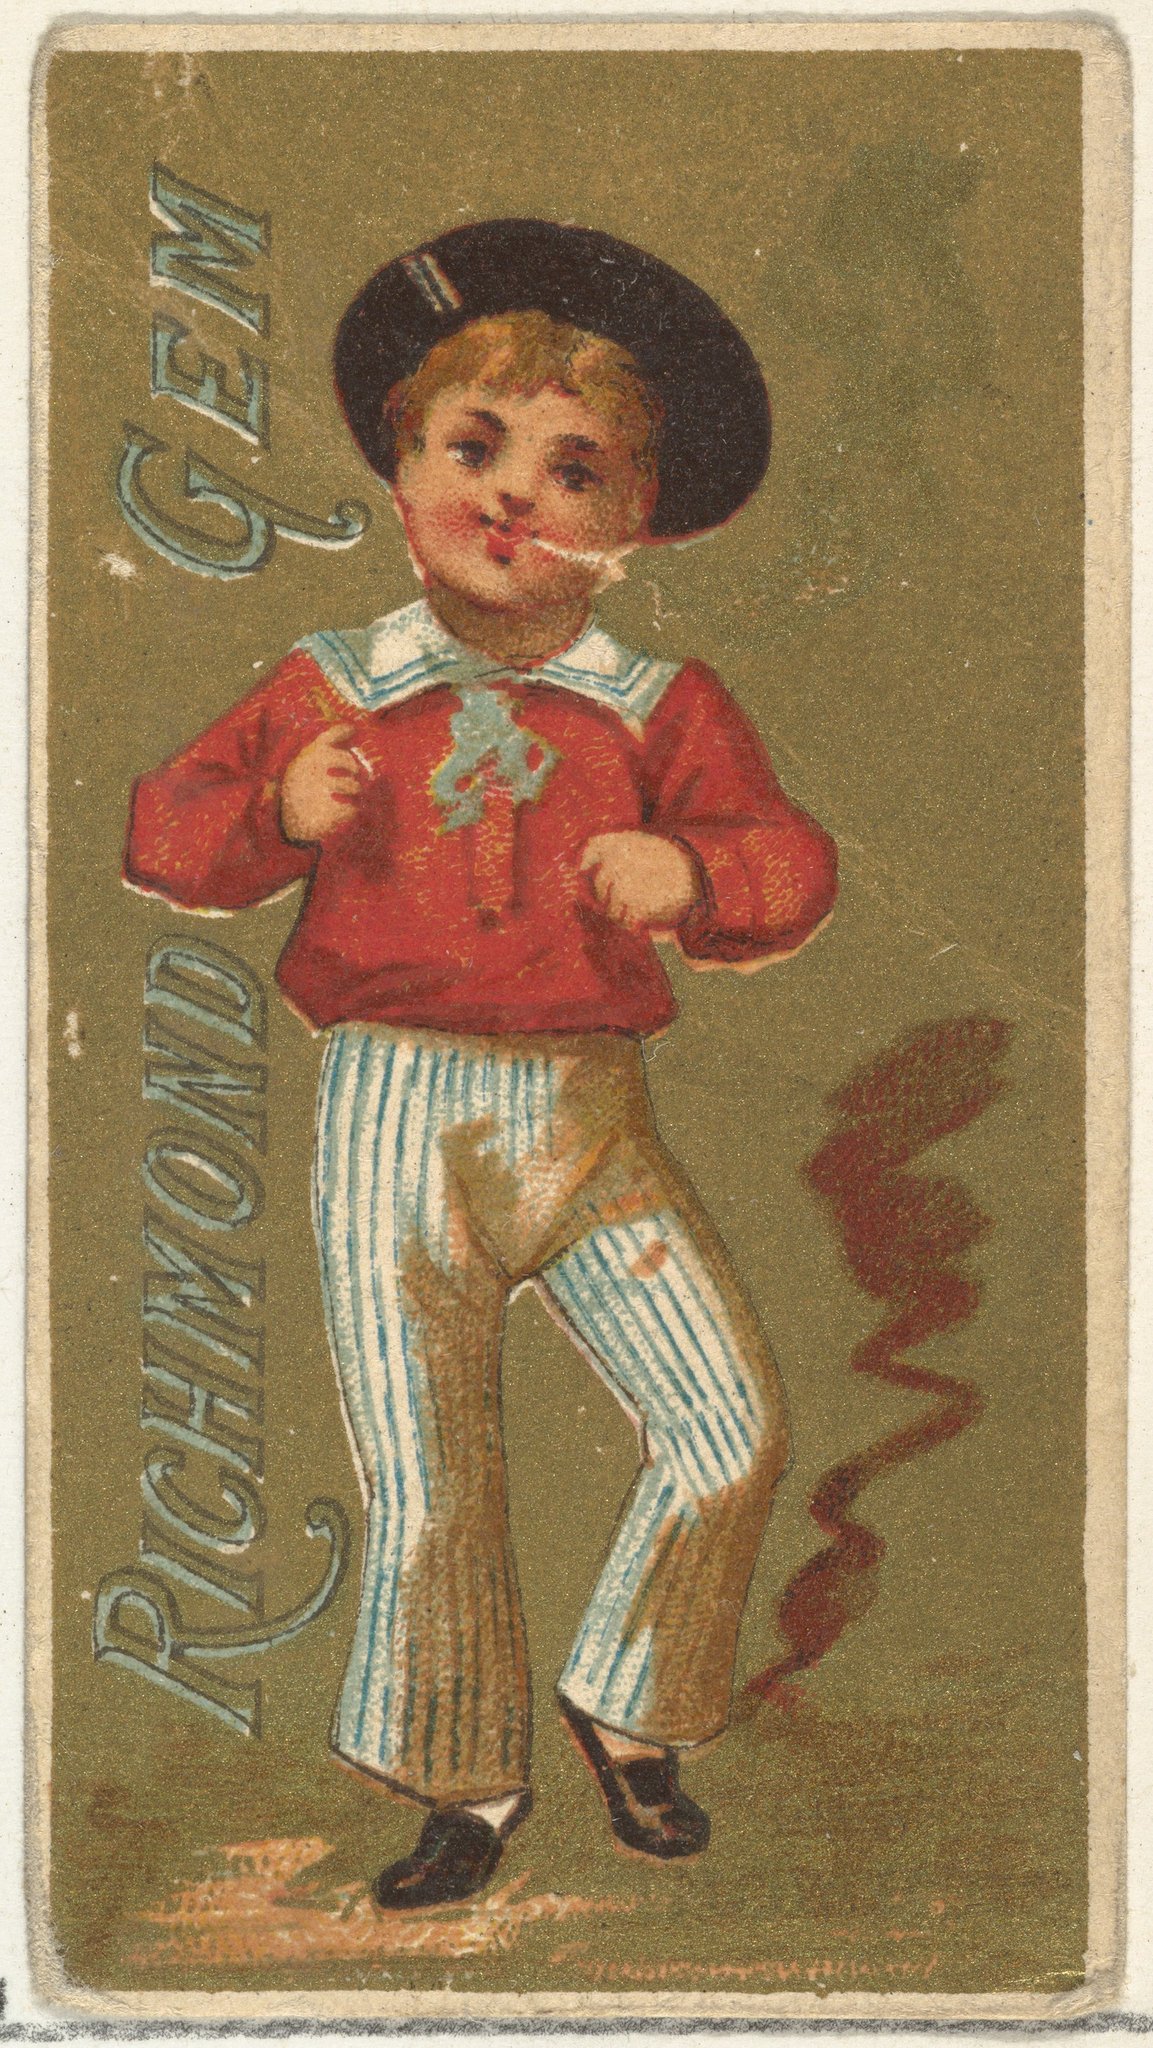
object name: print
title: From the Girls and Children series (N65) promoting Richmond Gem Cigarettes for Allen & Ginter brand tobacco products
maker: allen & ginter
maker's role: publisher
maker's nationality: american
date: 1886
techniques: color lithograph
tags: boys